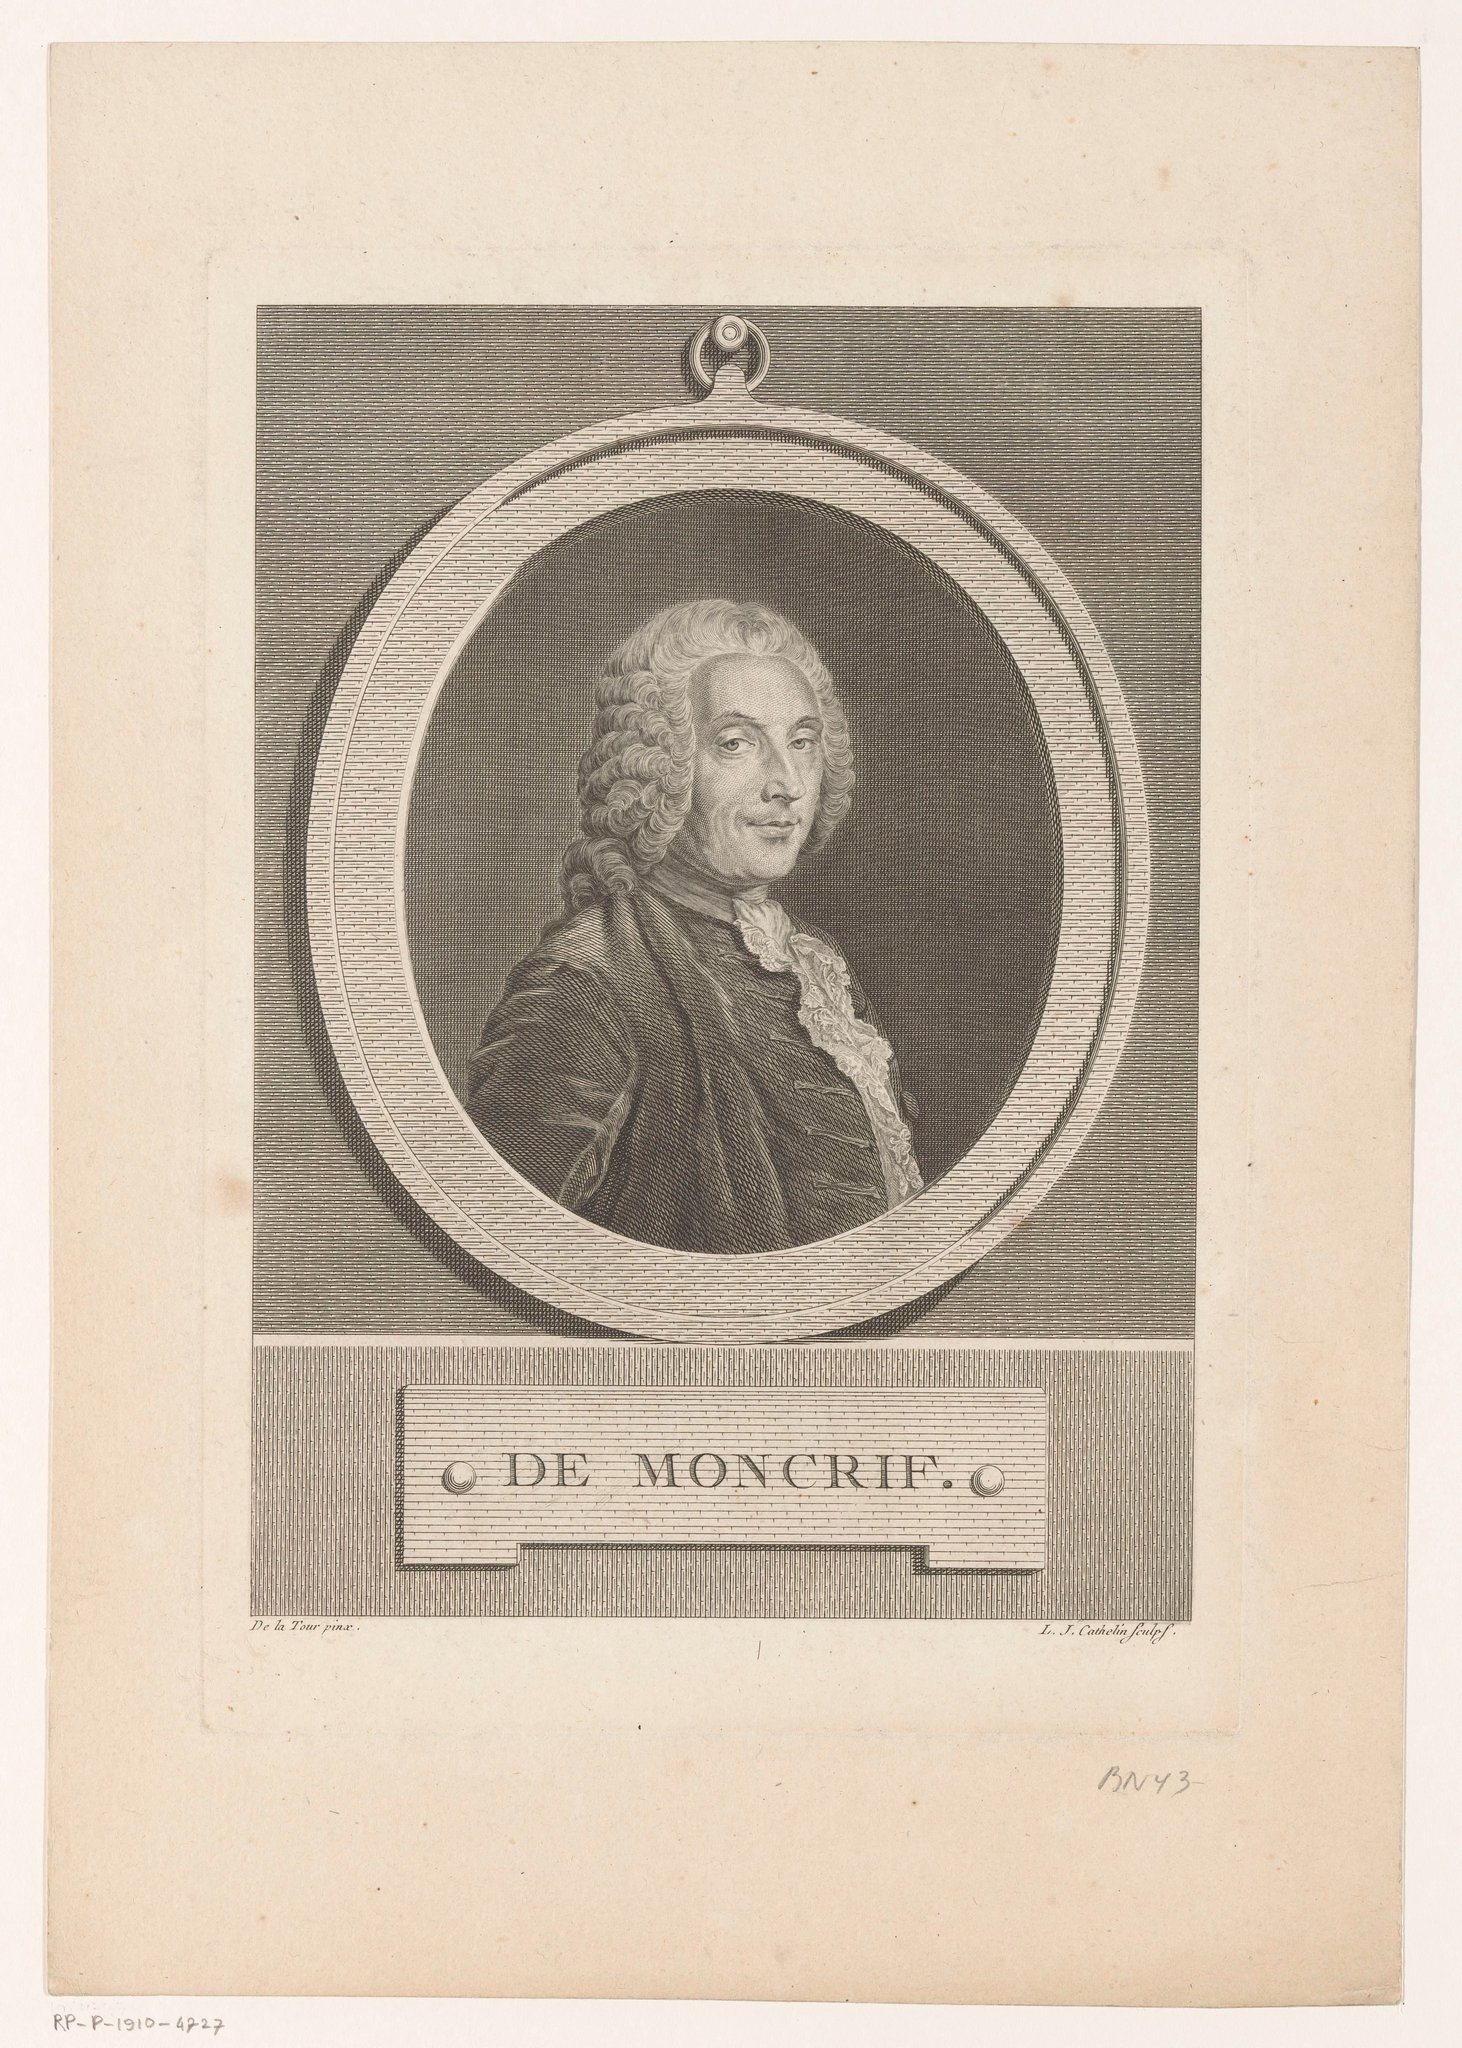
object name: print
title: Galerie françoise, ou portraits des hommes et femmes célèbres qui ont paru en France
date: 1771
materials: paper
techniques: engraving, etching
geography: france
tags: paris, historical persons, portrait of a writer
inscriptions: collector's mark: Lugt 2228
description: Maakt deel uit van een serie portretten, gepubliceerd door Herissant le fils in 1771.